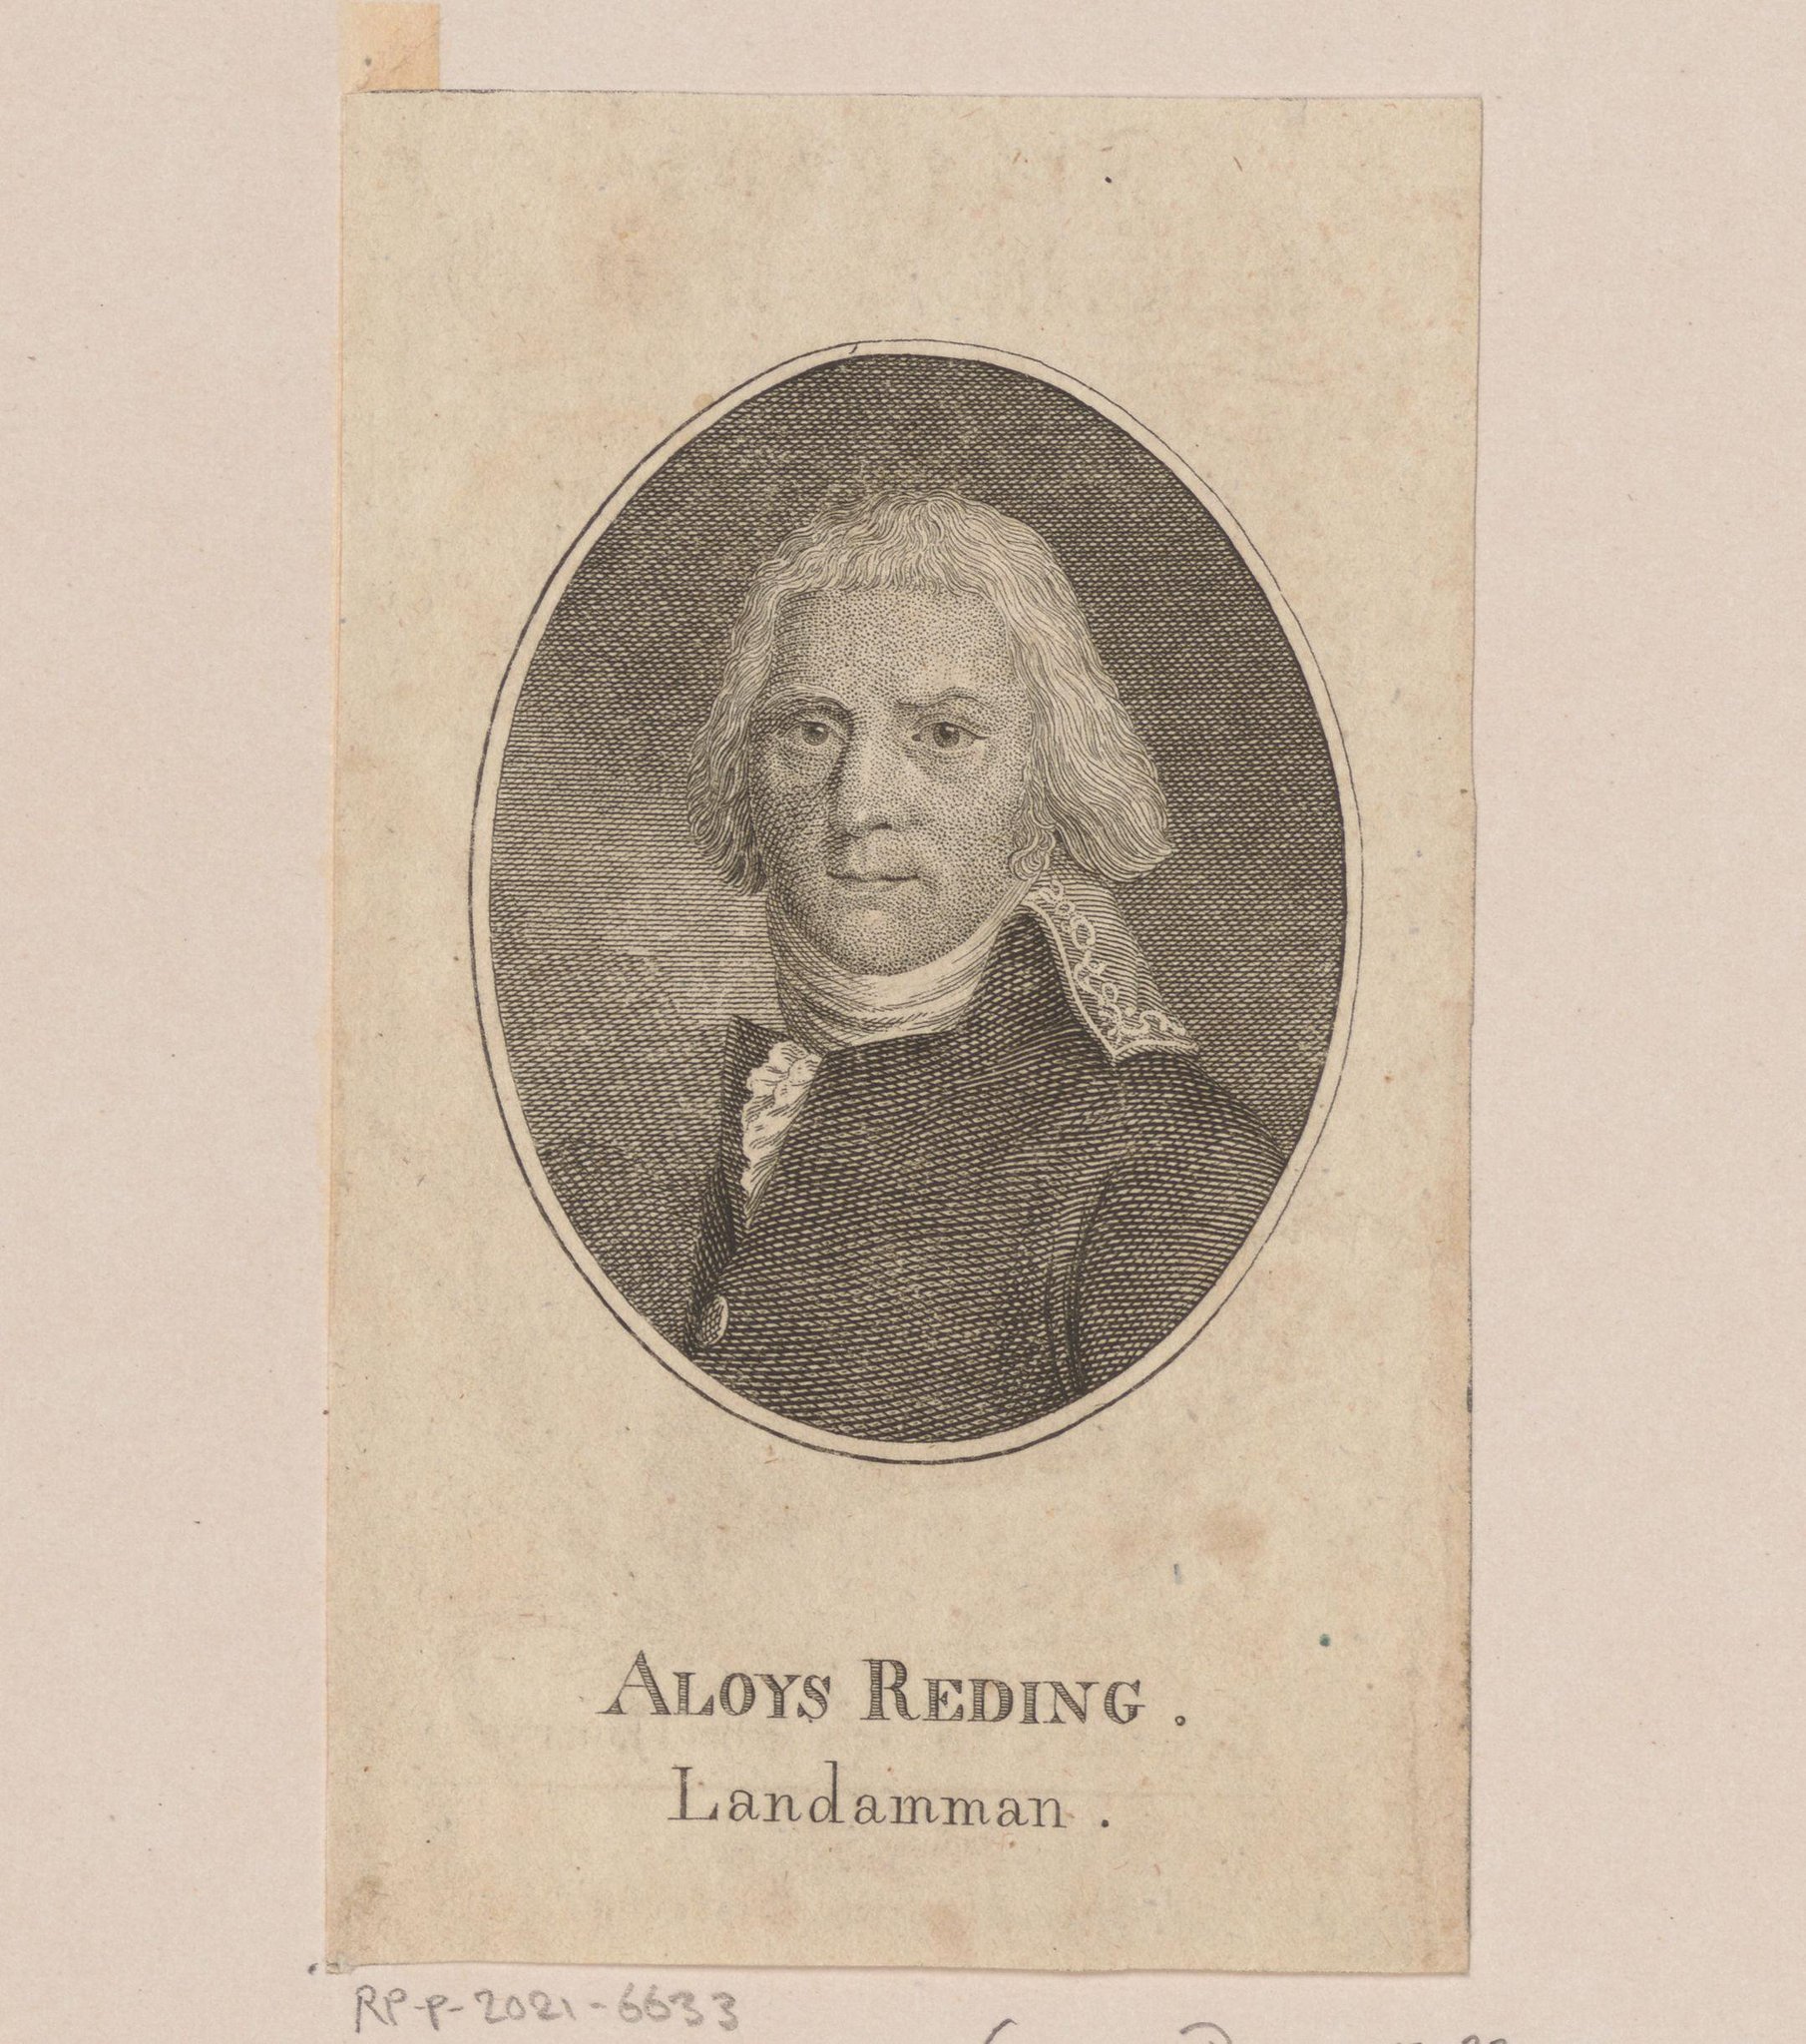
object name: print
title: Portret van Alois von Reding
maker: Anonymous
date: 1802-1804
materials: paper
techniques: etching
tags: politician, historical persons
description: Prent mogelijk uit: Friedens-Almanach von 1803 (...). Göttingen: Heinrich Dieterich, [1803-1804]. Of een eerdere publicatie (1802-1803).